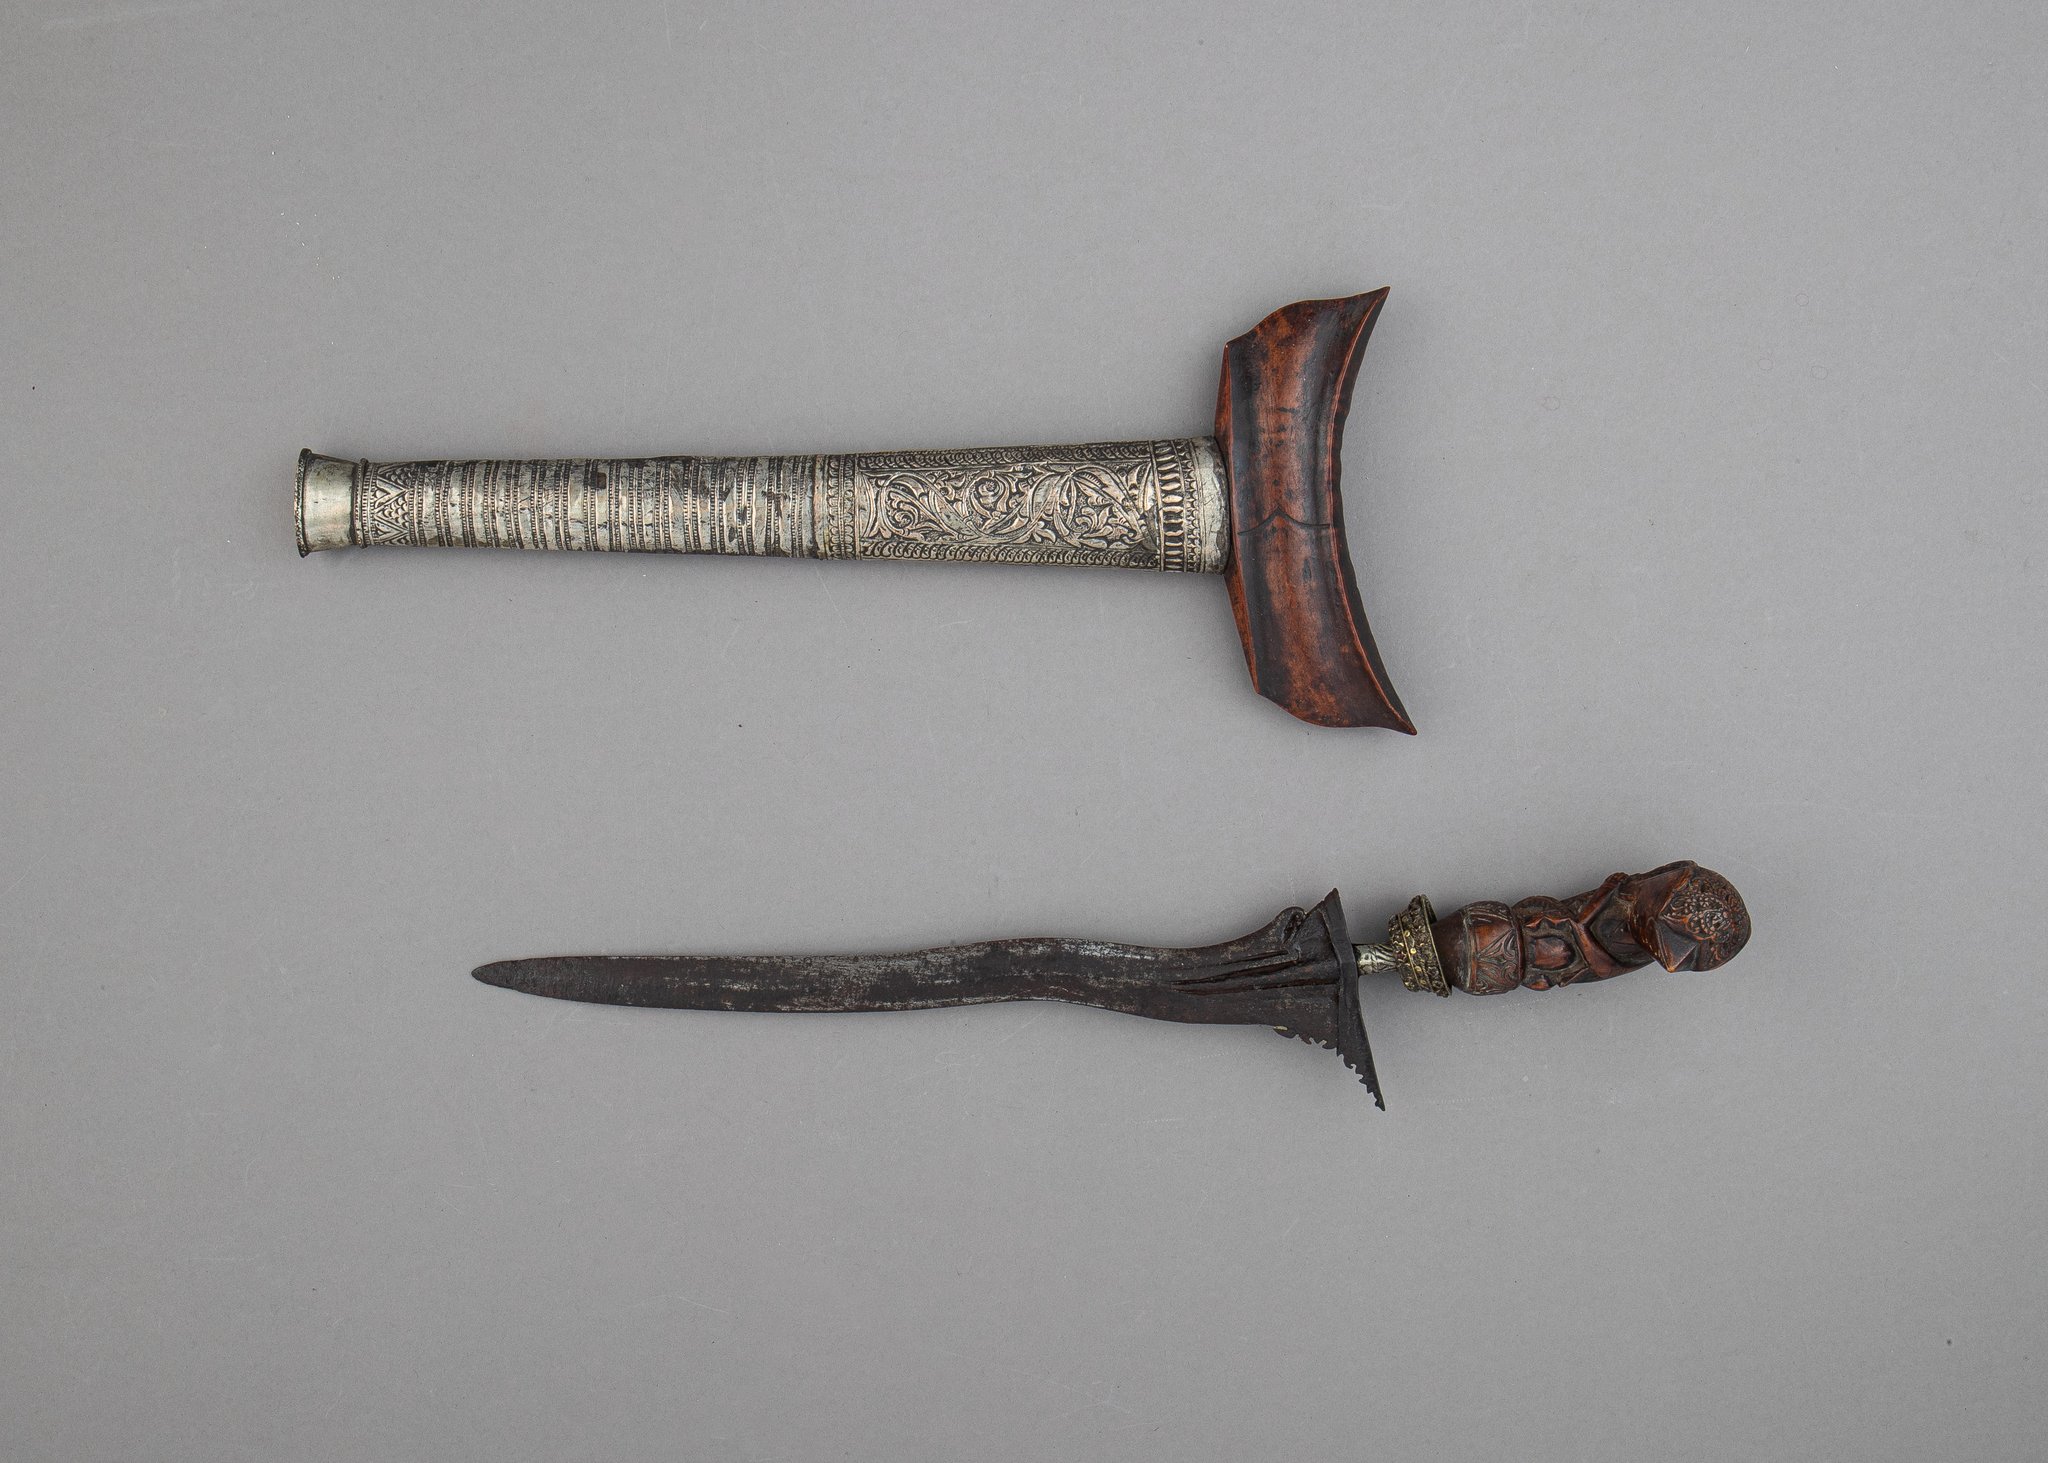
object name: kris with sheath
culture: minangkabau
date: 1501-1900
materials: brass, silver, steel, wood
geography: indonesia